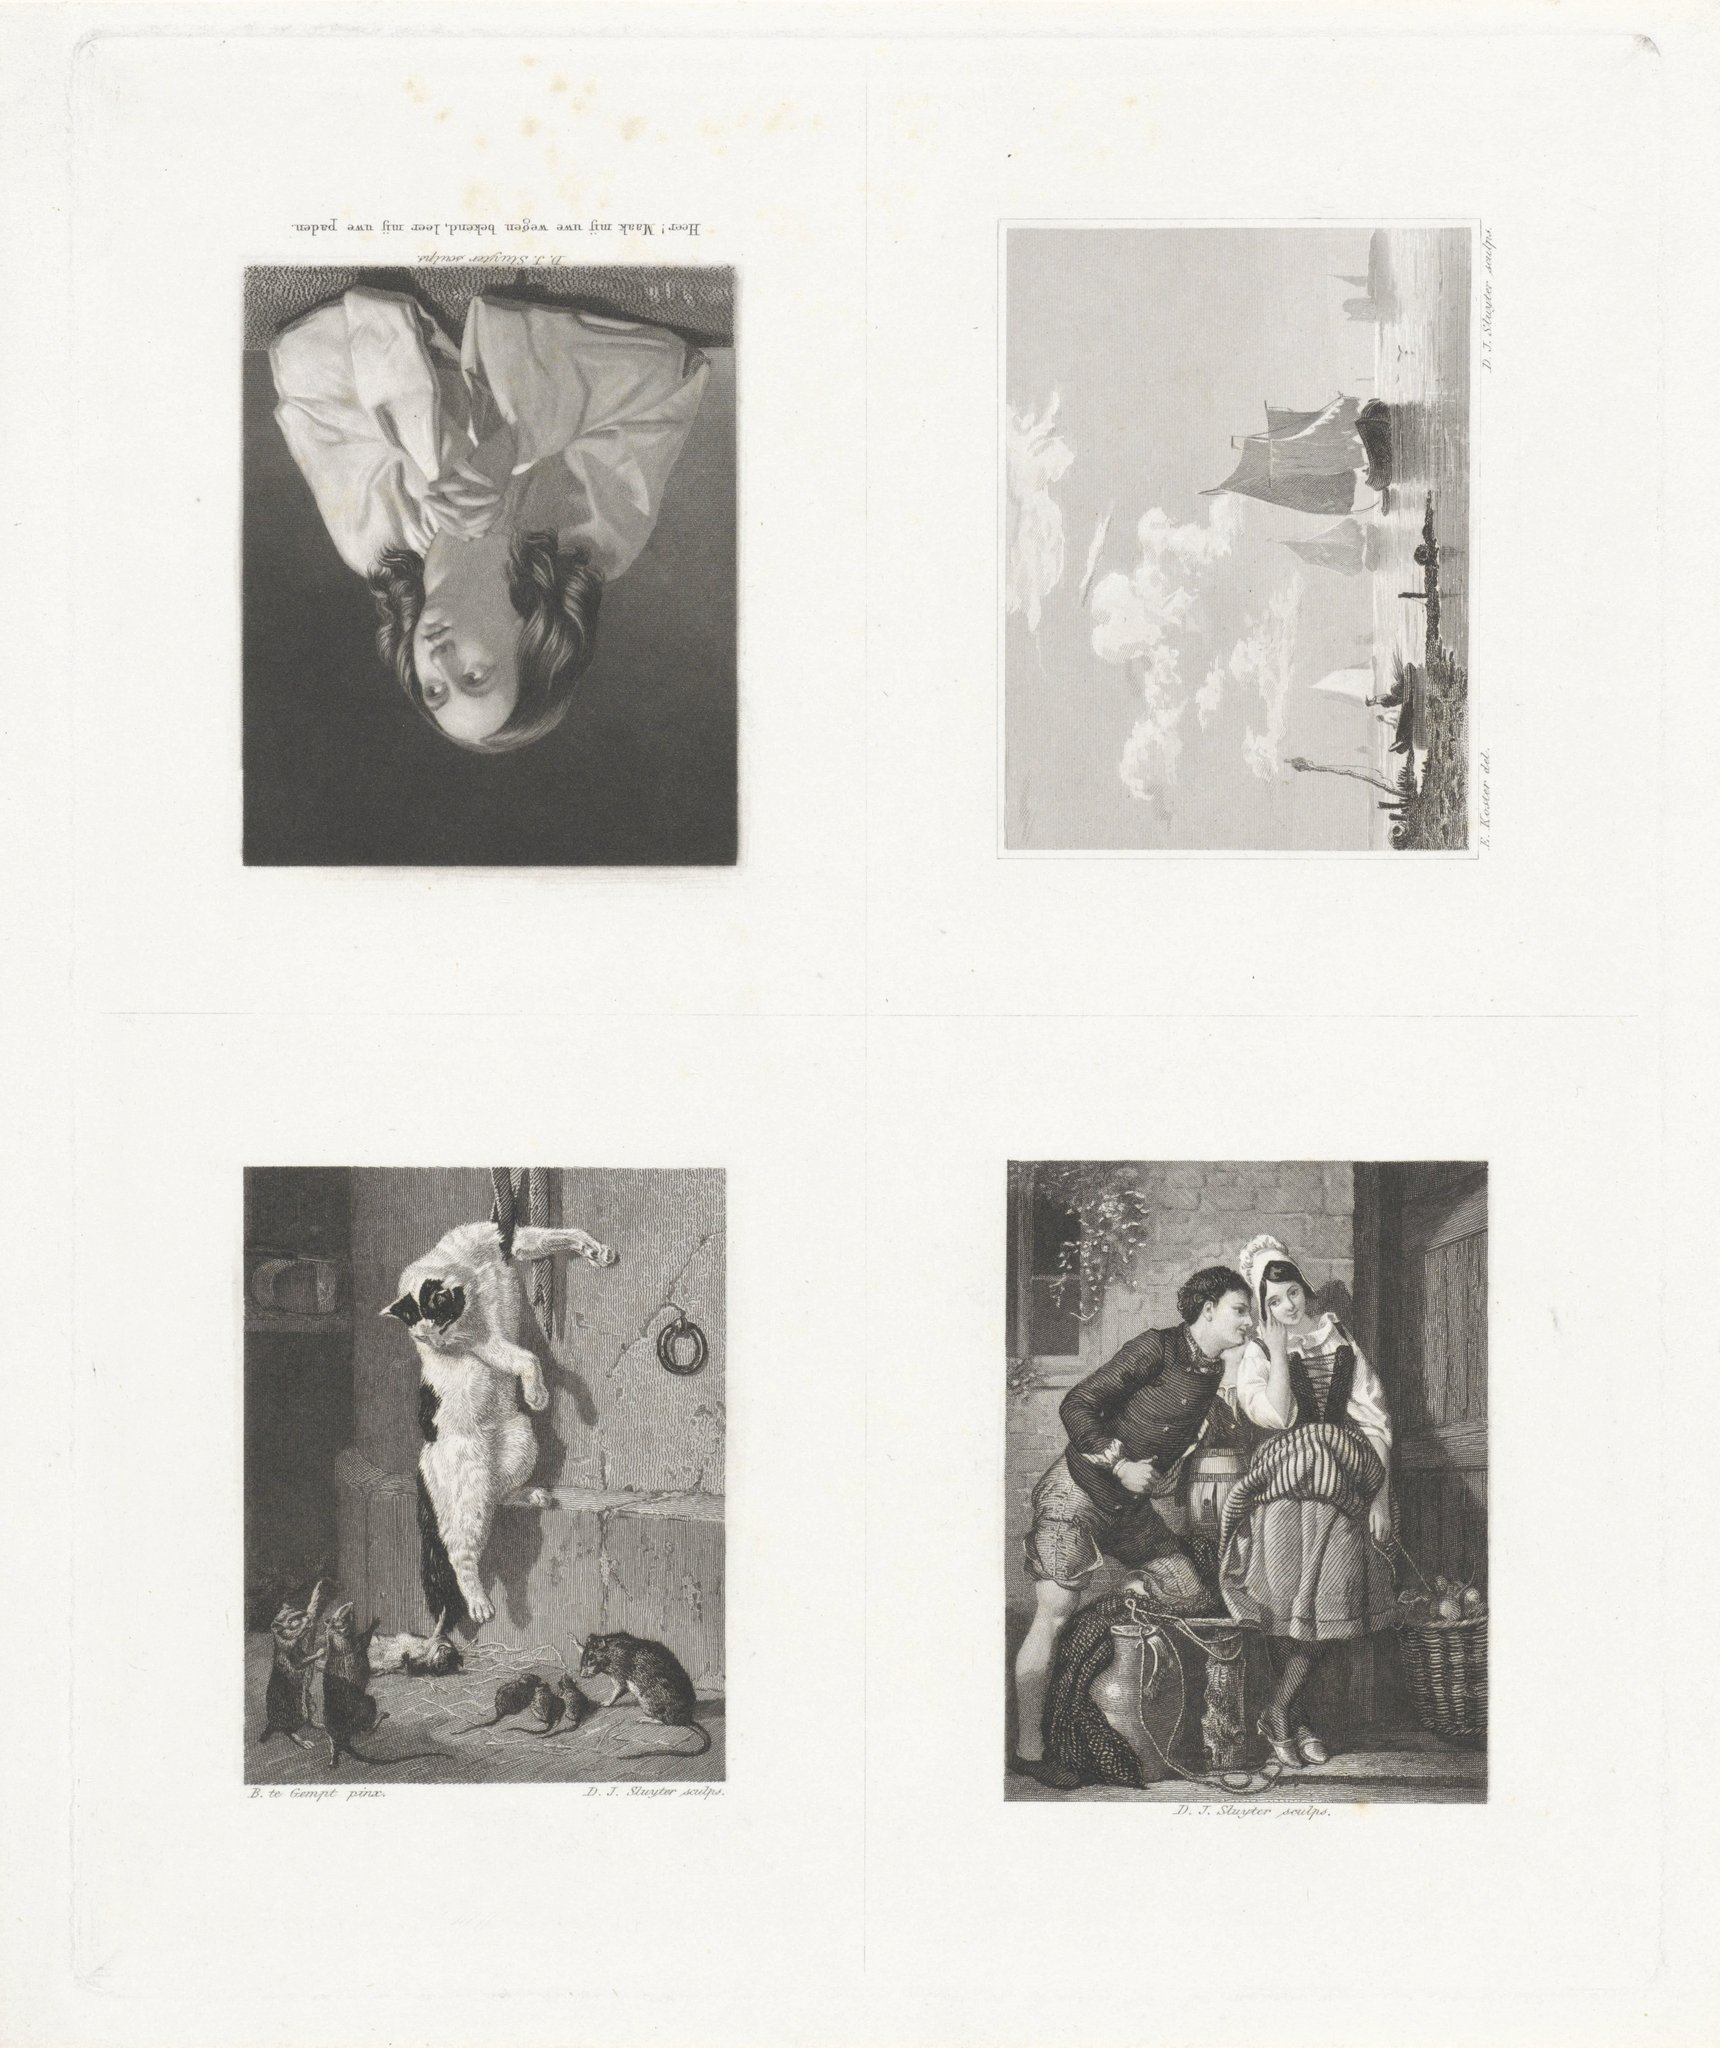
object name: print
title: Biddende jonge vrouw - Muizenfeest - Smoezend koppel - Zeilscheepjes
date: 1826-1886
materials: paper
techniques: aquatint, engraving, etching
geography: amsterdam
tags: sailing-ship, sailing-boat, cat and mouse, couple of lovers, one person praying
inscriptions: collector's mark: Lugt 2228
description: Vier boekillustraties op een plaat. Linksboven een biddende jonge vrouw, met onderschrift. Linksonder een kat die met zijn poot verstrikt geraakt is in een riempje aan een muur. De muizen en ratten op de grond lachen de hulpeloze kat uit. Rechtsonder een jongeman die zich voorover buigt om iets in de oren van een blozend meisje te fluisteren. Rechtsboven een rivier met zeil- en roeiboten.